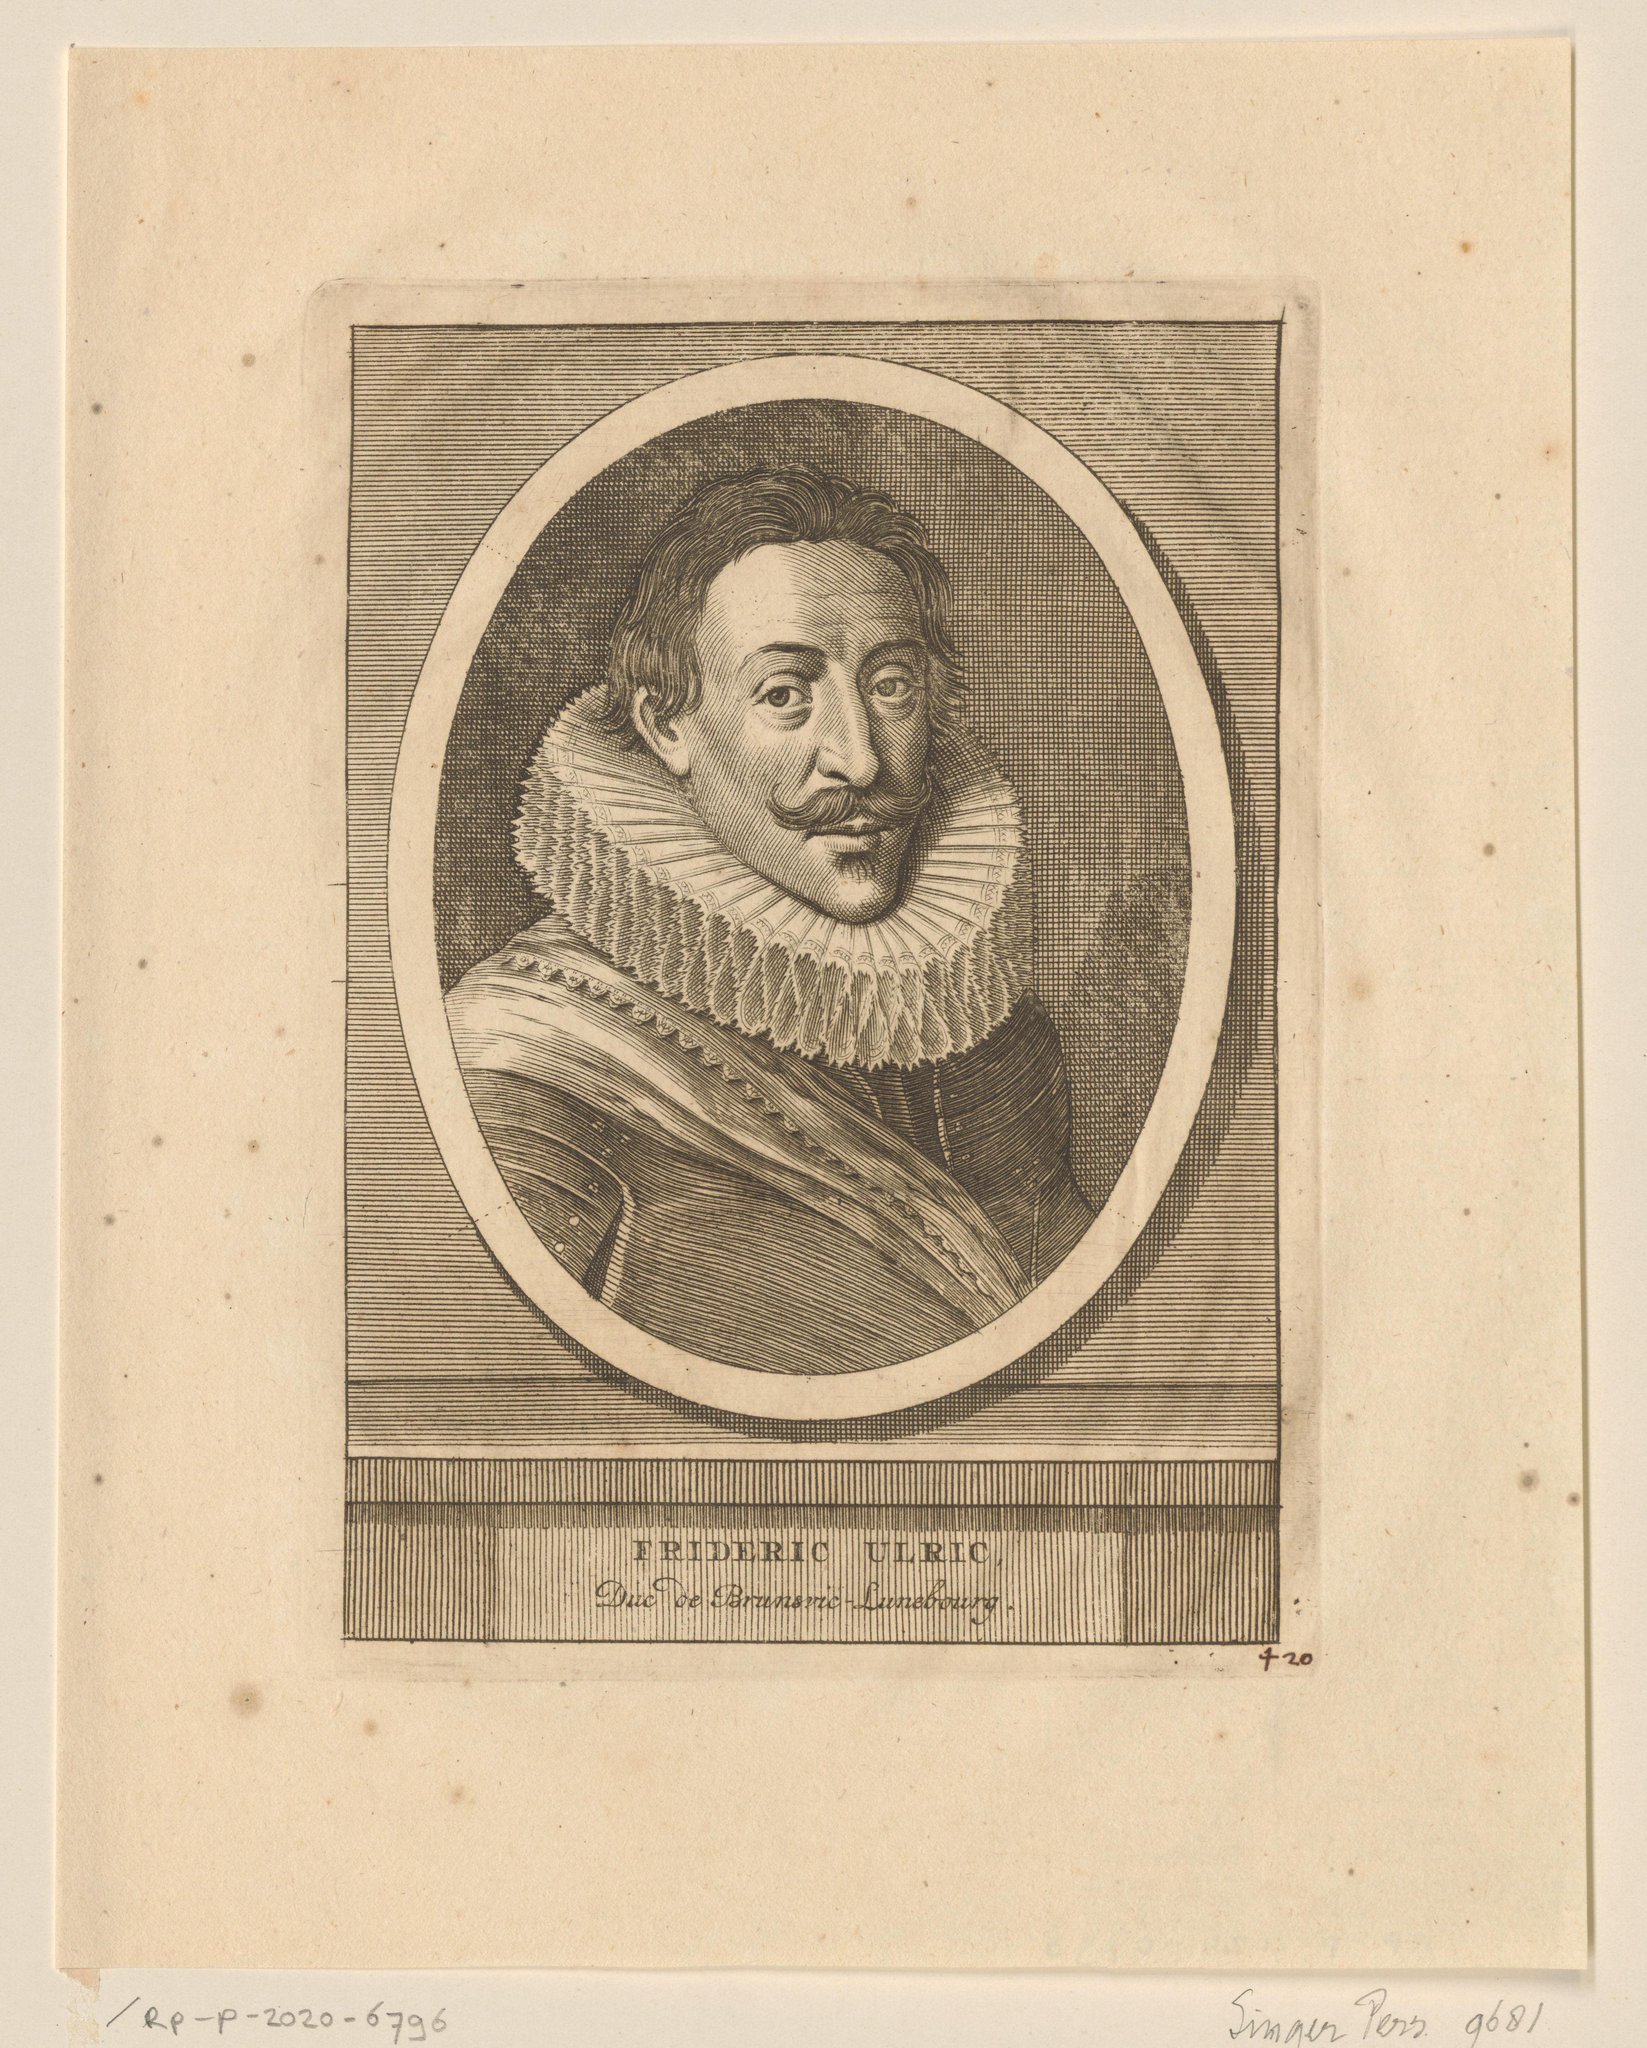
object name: print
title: Portret van Frederik Ulrich van Brunswijk-Wolfenbüttel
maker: Anonymous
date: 1650-1750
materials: paper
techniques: engraving, etching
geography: france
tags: armour, historical persons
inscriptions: number: ‘+20’